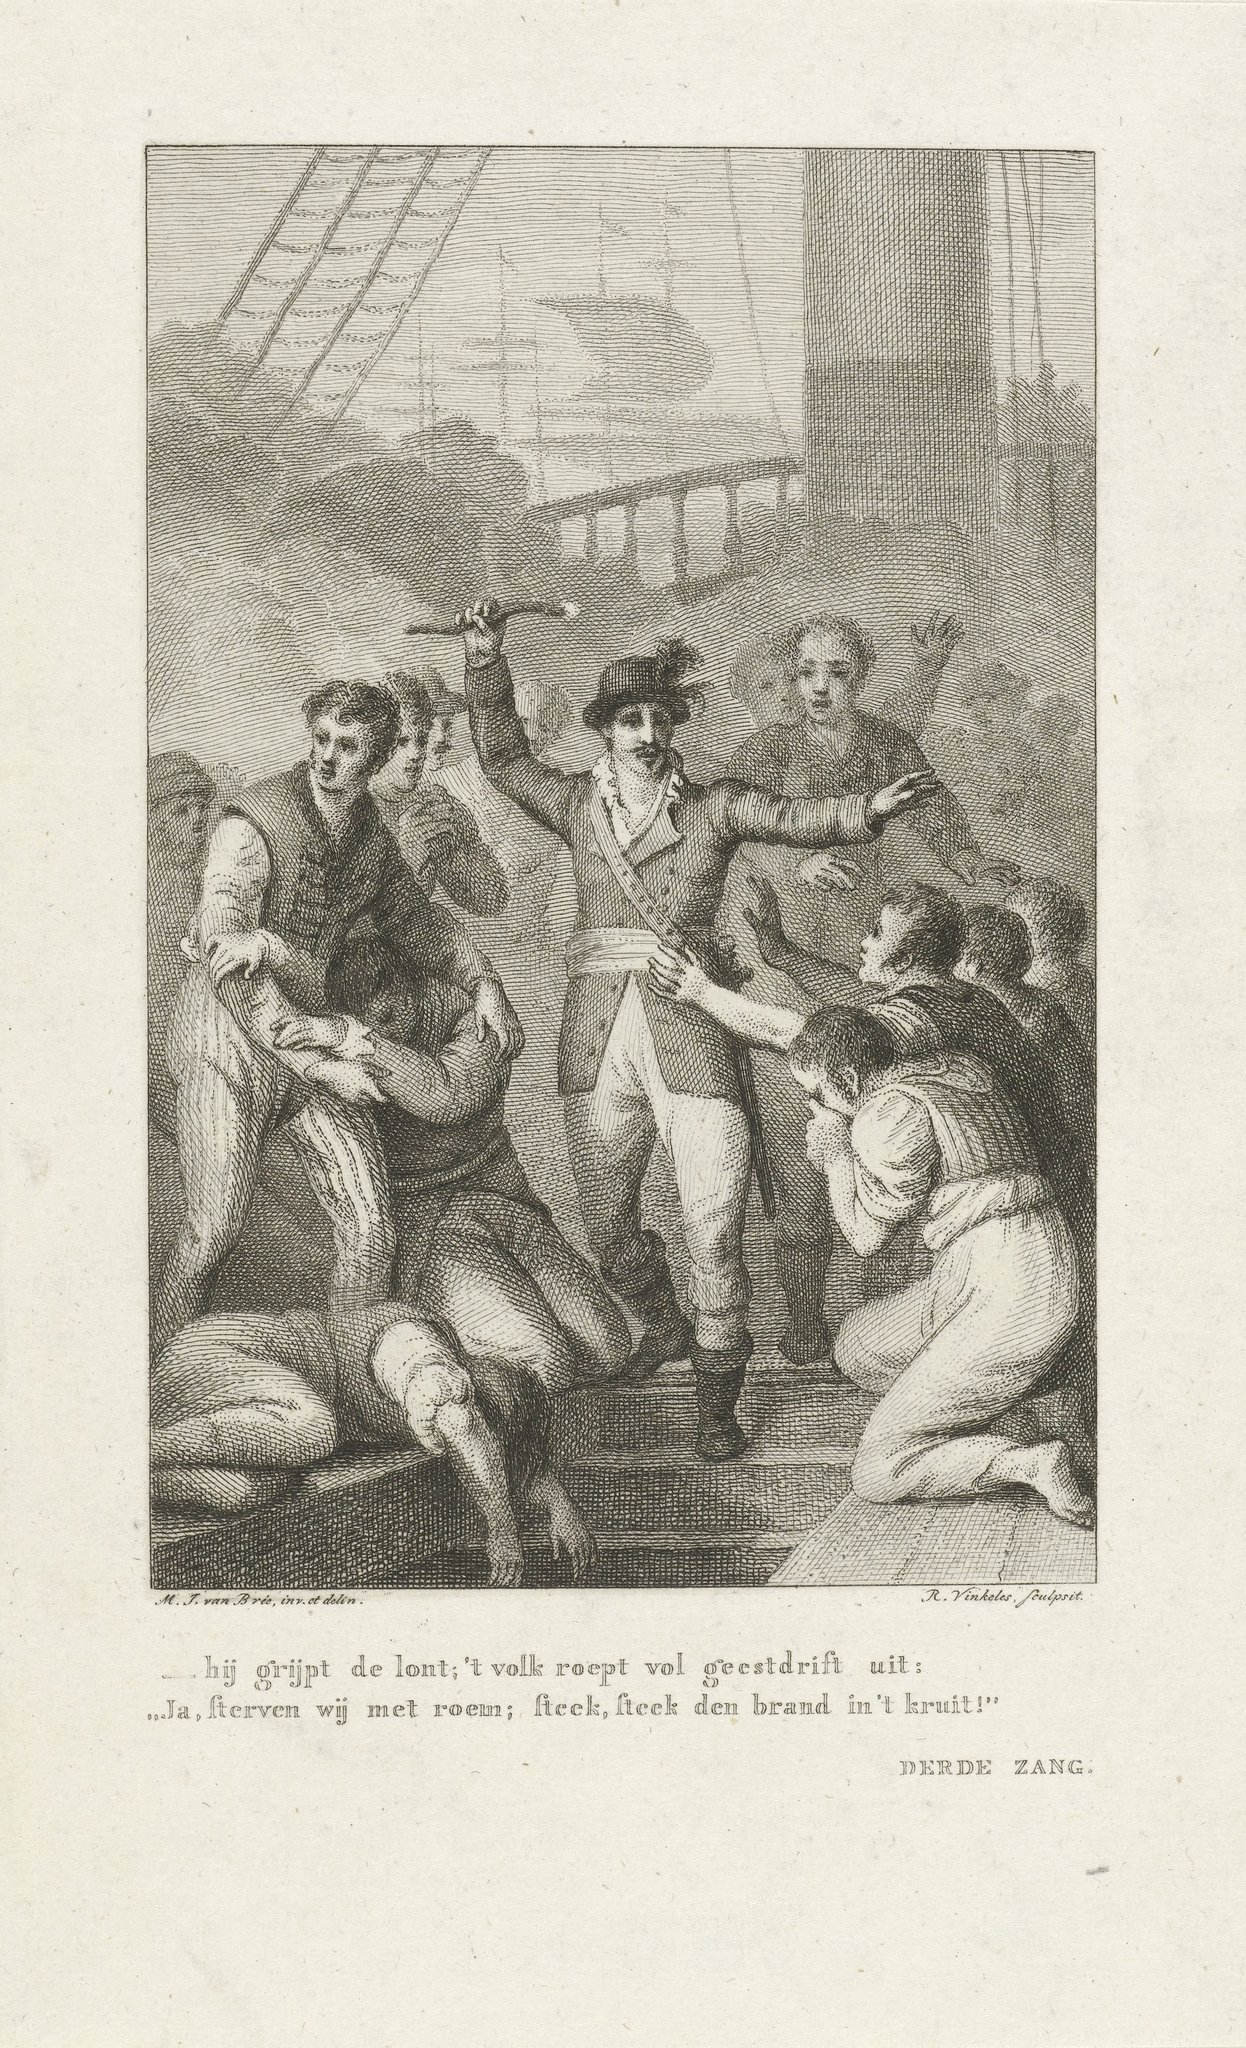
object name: print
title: Reinier Claeszen gooit de lont in het kruit, 1606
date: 1810-1812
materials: paper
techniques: etching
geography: netherlands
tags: self-sacrifice, death in the service of a higher purpose - ee - death not certain; wounded person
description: De vice-admiraal van Zeeland, Reinier Claeszen gooit na een tweedaagse slag tegen een Spaanse overmacht de lont in het kruit en laat zijn reddeloze schip de lucht in vliegen, 7 oktober 1606. Met onderschrift van 2 regels in het Nederlands.